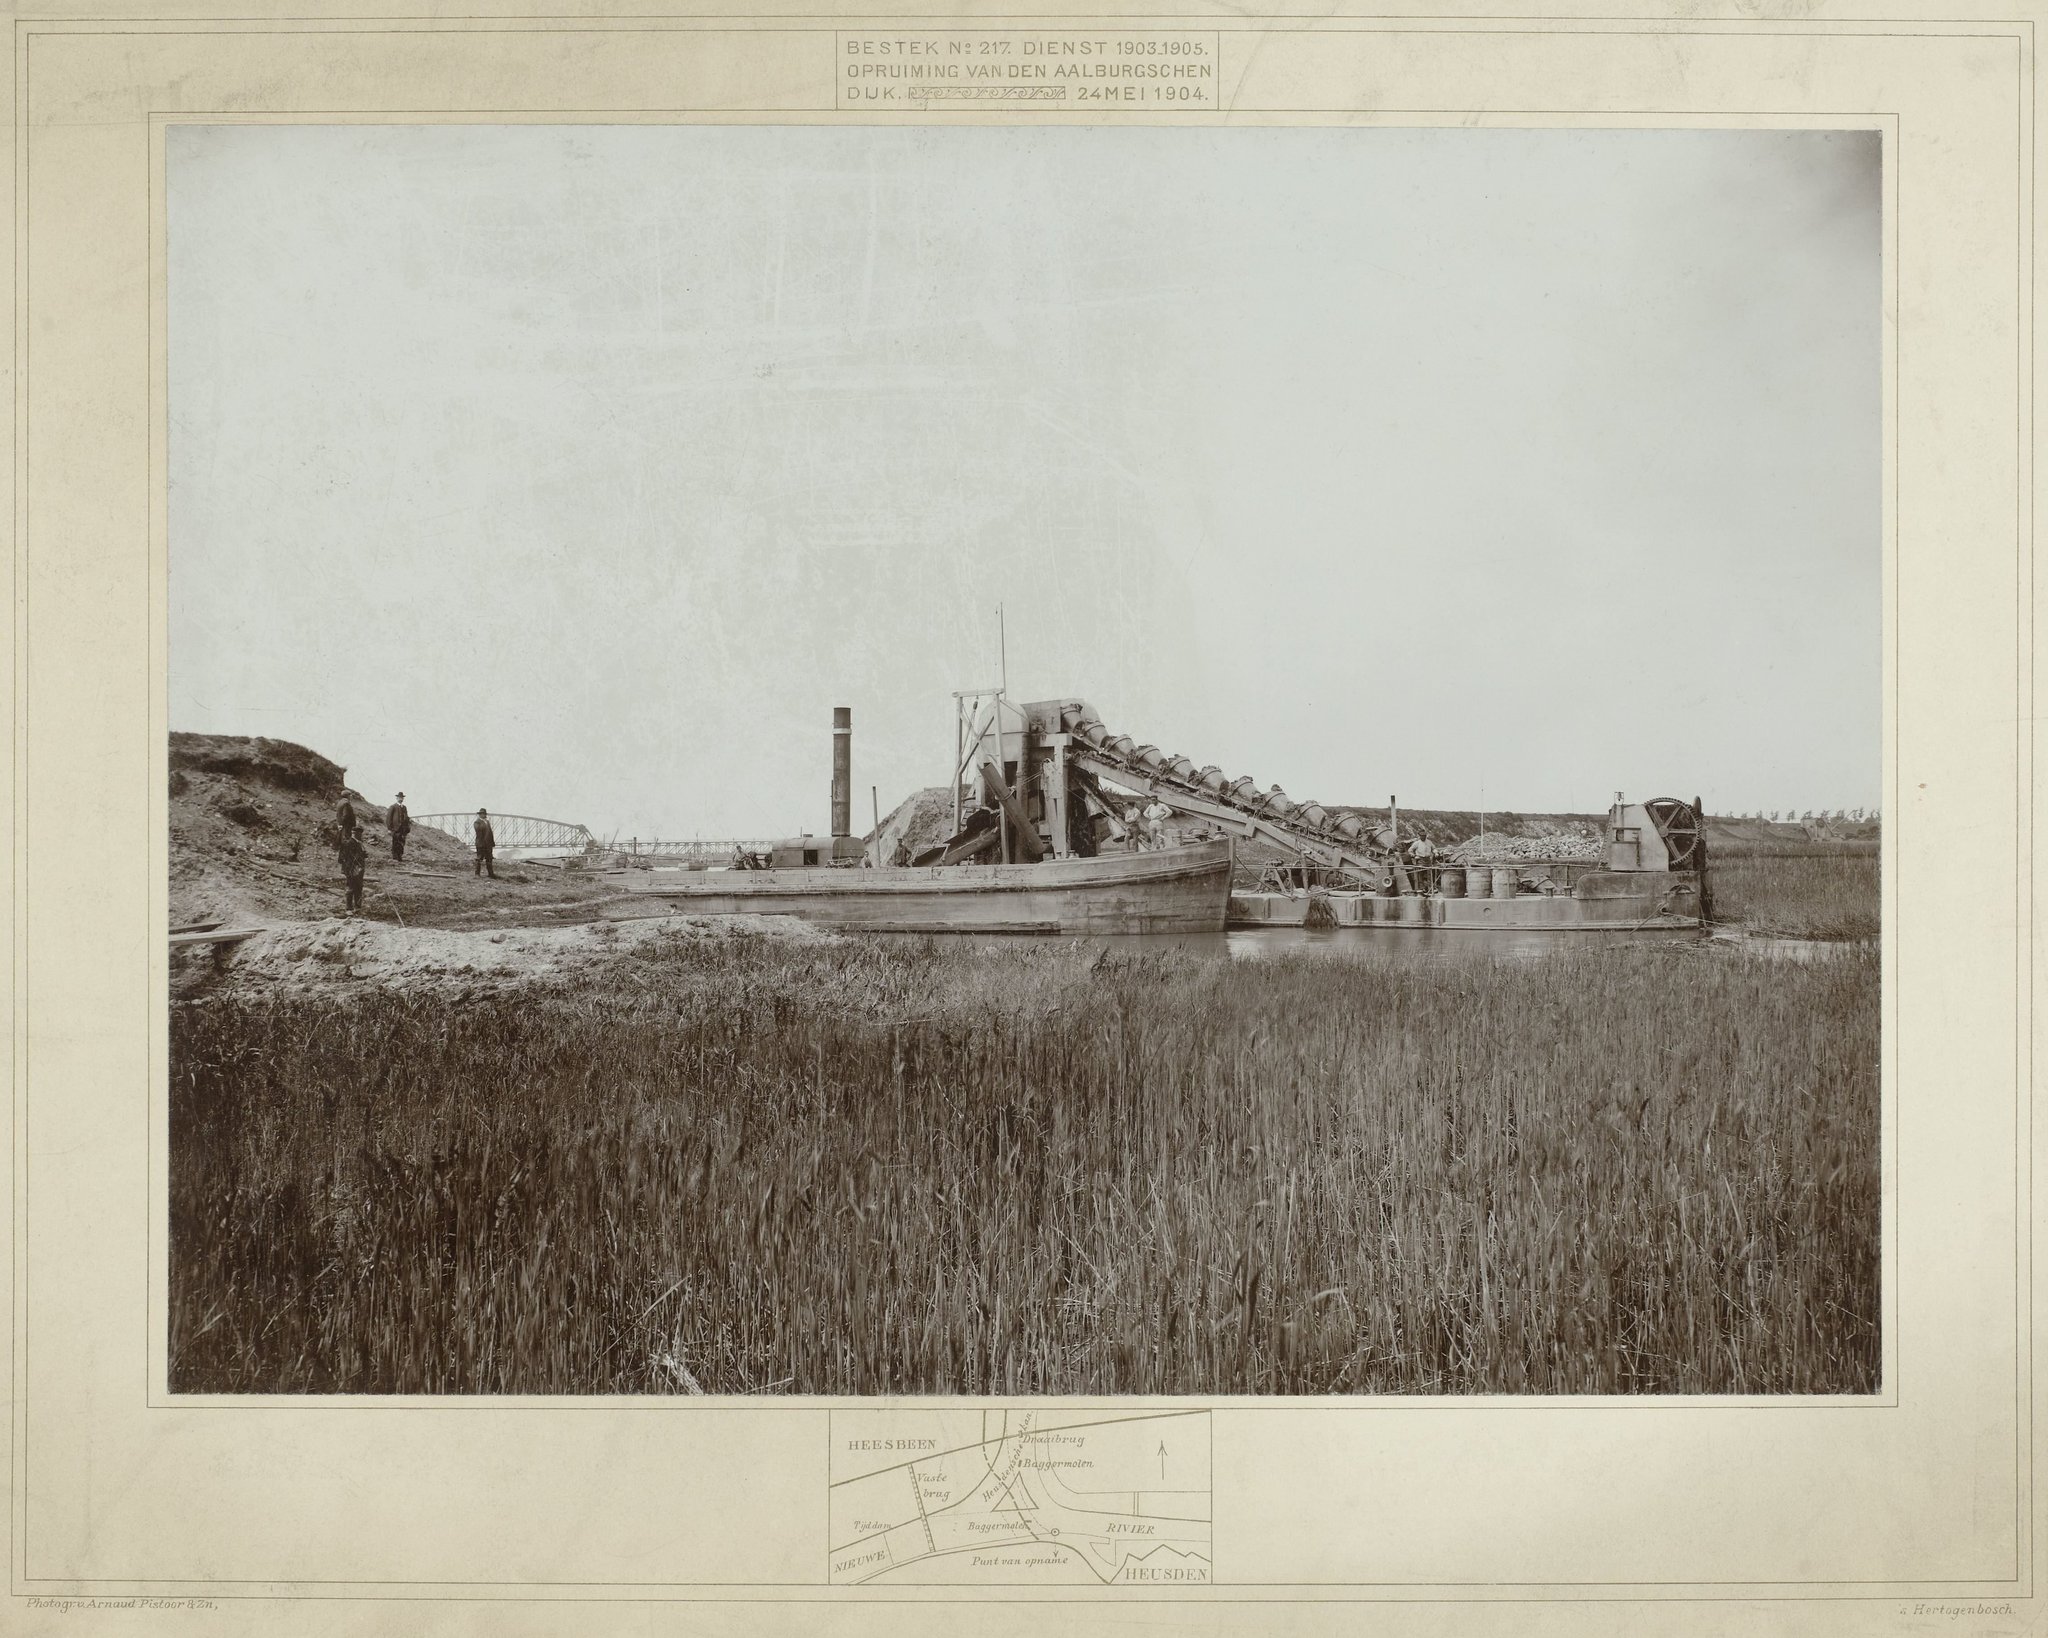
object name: photograph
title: Bestek nr. 217, dienst 1903, 1905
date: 1904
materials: cardboard, paper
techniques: photography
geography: den bosch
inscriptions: date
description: Foto op karton, van waterbouwkundige werken (ten behoeve van de scheiding tussen maas en waal. Tekst boven de foto, onder de foto een situatiekaartje. Gesigneerd en gedateerd. Opschrift; b.: 'Opruiming van den Aalburgschen Dijk 24 mei 1904.